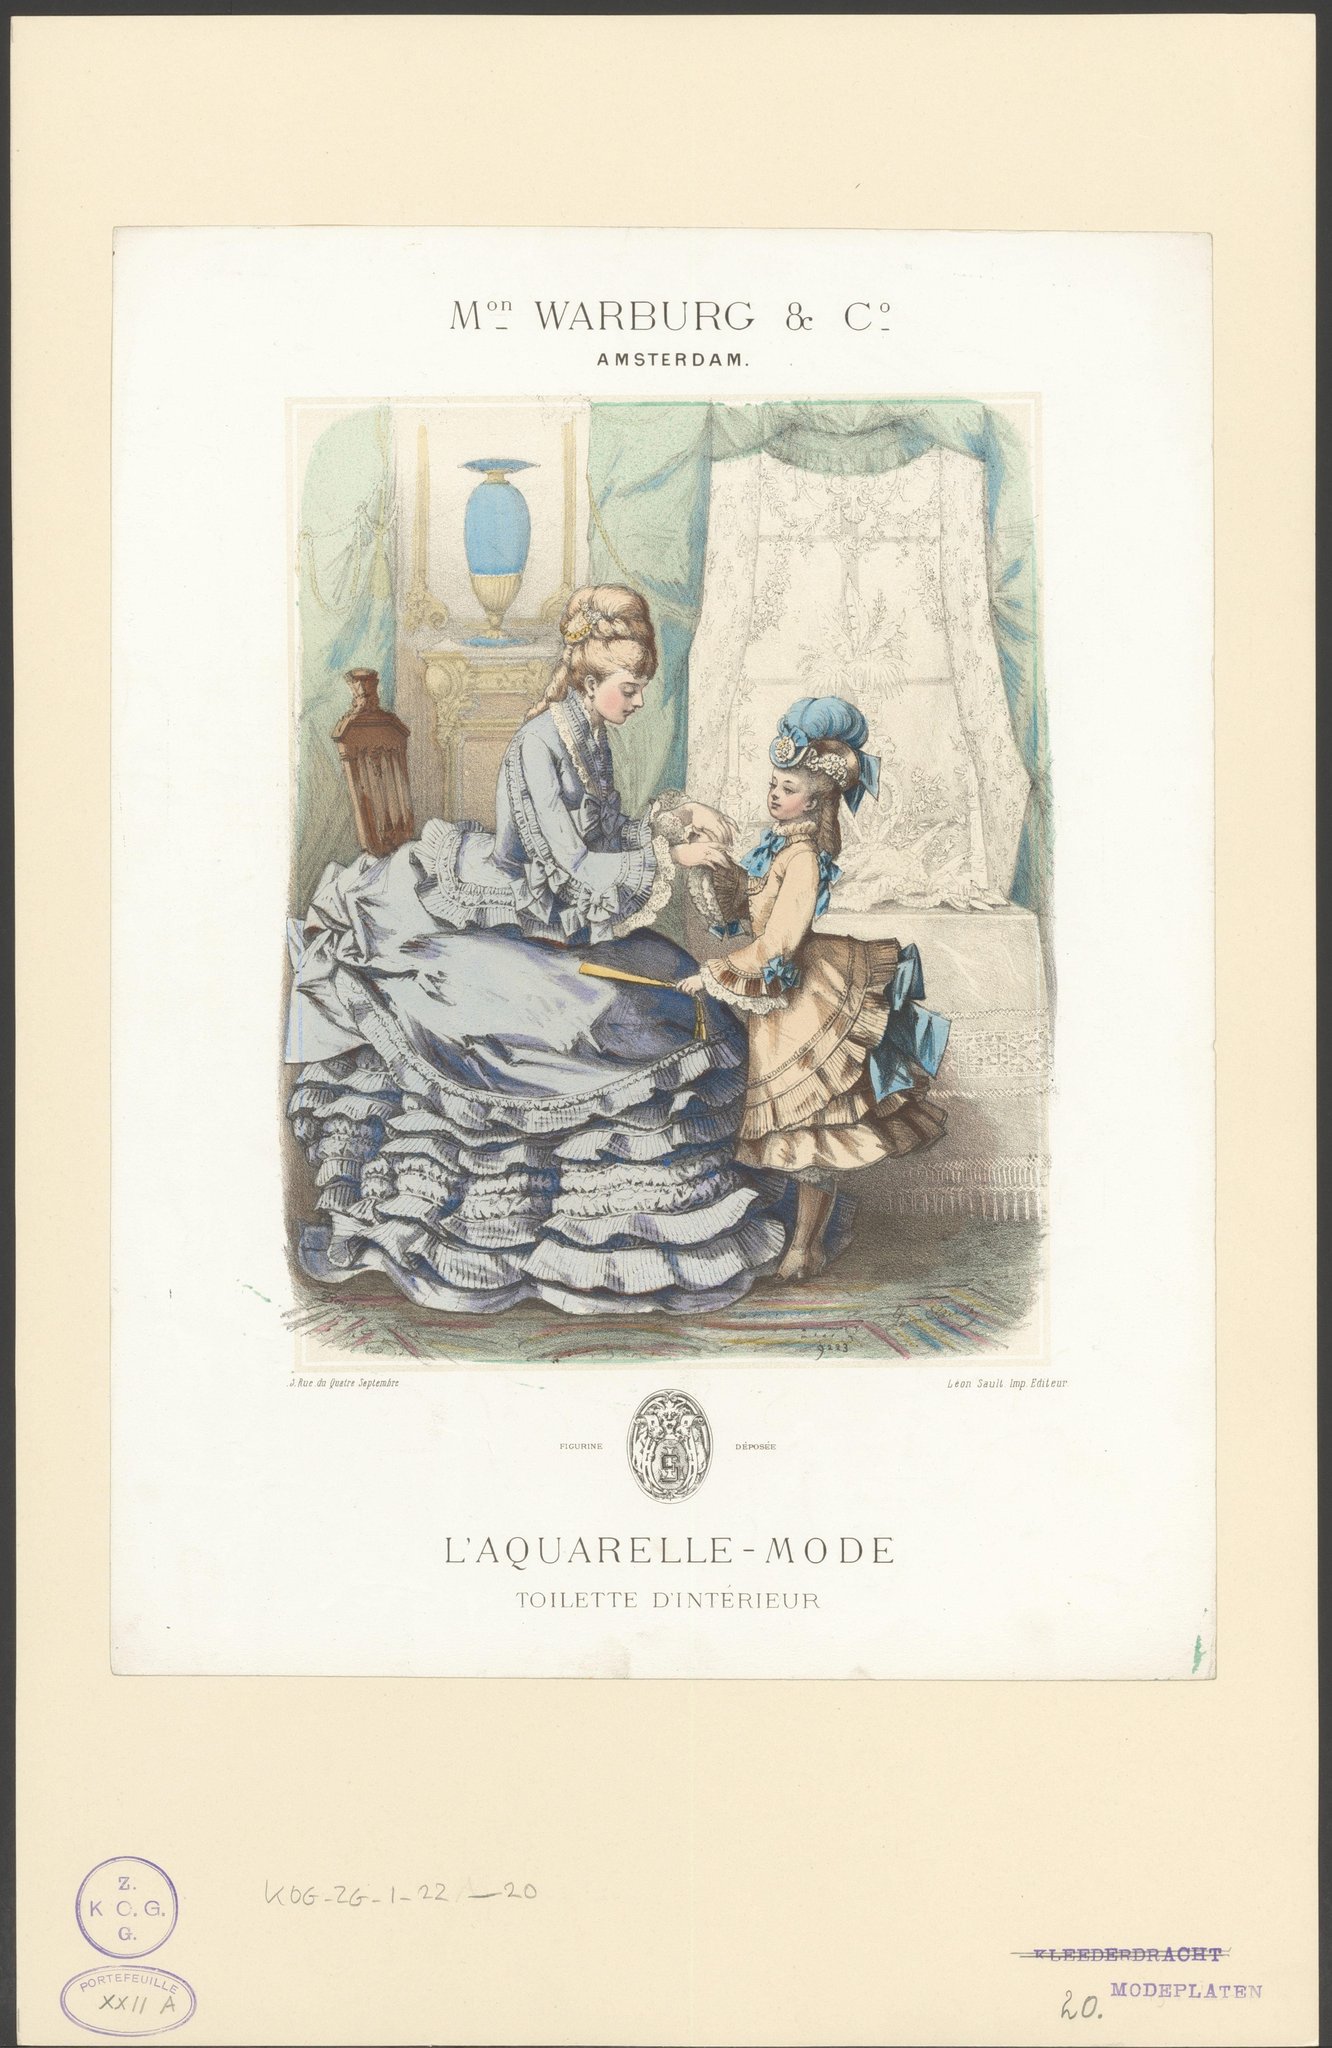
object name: fashion print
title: Moeder en dochter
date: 1875-1886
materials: paper, watercolor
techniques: hand coloring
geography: paris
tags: mother with daughter(s) (mother-love), fashion plates, clothes, costume (+ women's clothes), dress, gown (+ women's clothes), dressing oneself, getting dressed - aa - female human figure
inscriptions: collector's mark: Lugt 1641, collector's mark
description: Moeder helpt haar dochter met haar kleding. In de slaapkamer. Met vermelding van 'Mon. Warburg & Co. Amsterdam'. Prent uit het modetijdschrift L'Aquarelle-Mode (1866-1892). nr. 9223. Onderwerpsrubrieken binnen de Atlas Zeden en Gewoonten: De Kleeding, Modeplaten.